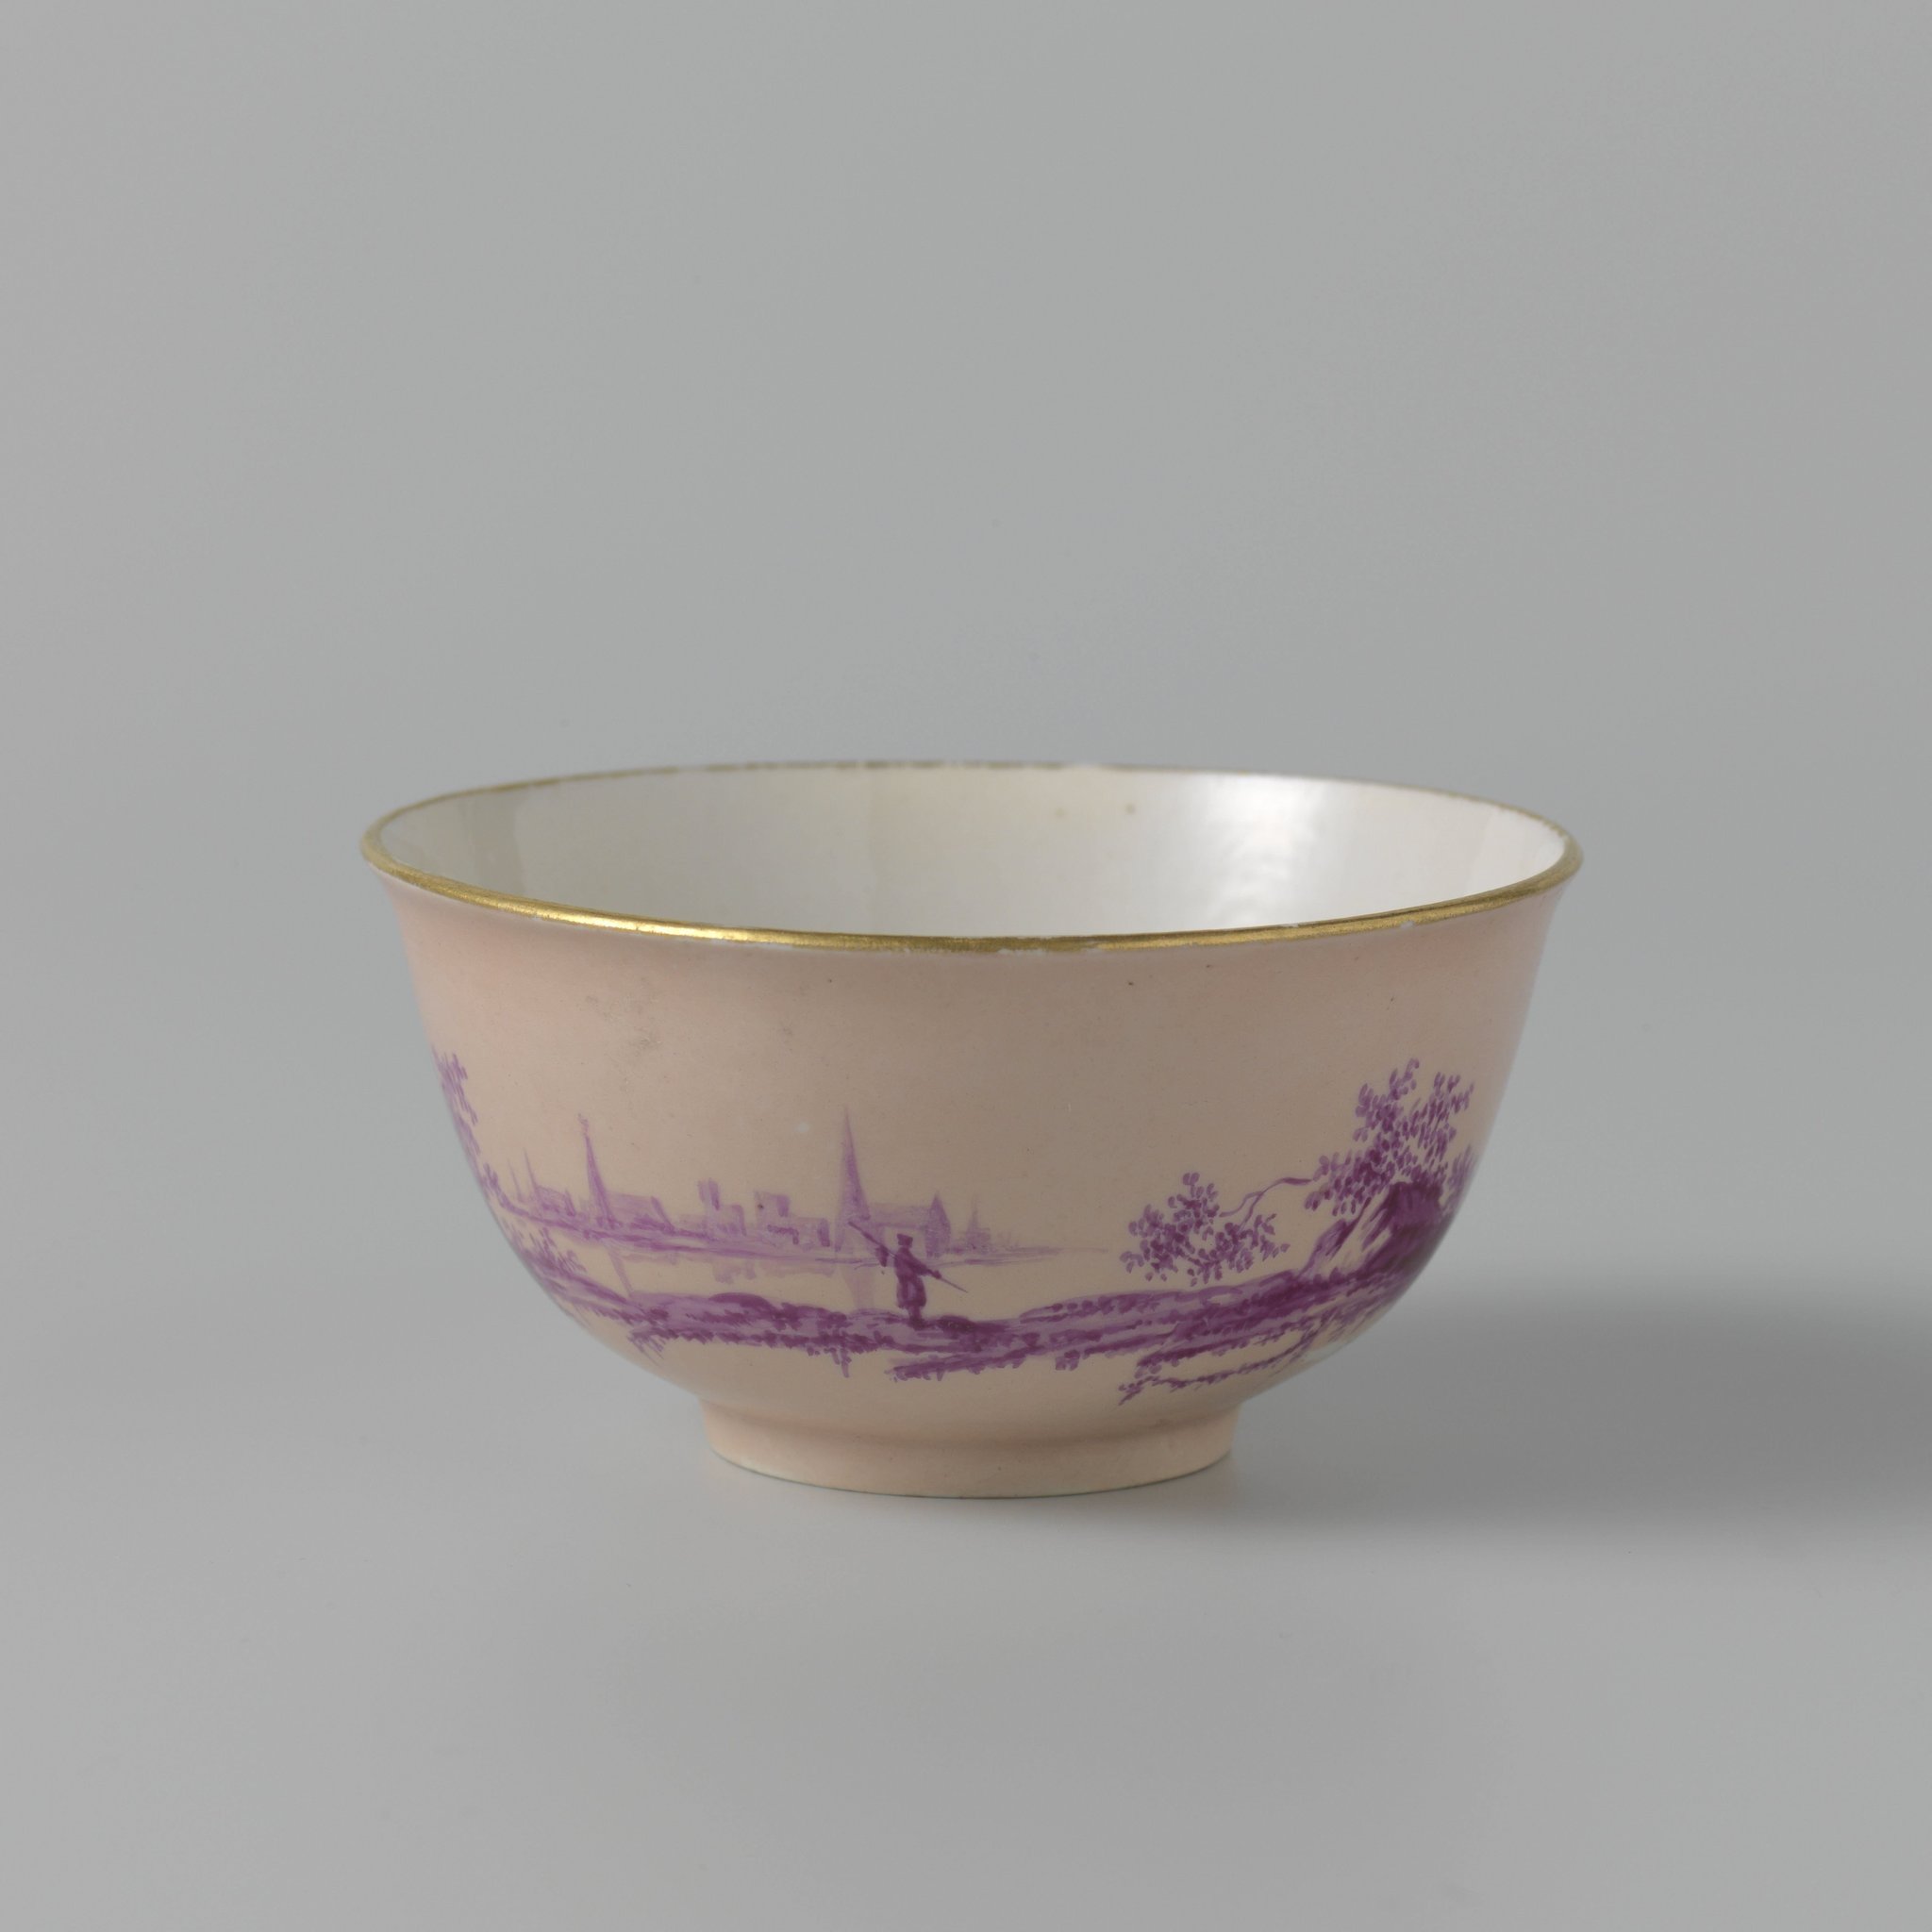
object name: cup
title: Part of a coffee and tea service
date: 1774-1778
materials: porcelain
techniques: painted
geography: loosdrecht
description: Kop van porselein, deel van een koffie- en theeservies. Beschilderd in bietenrood op een lichtrose fond, met figuren in een rivierlandschap, met gebouwen en ruines.